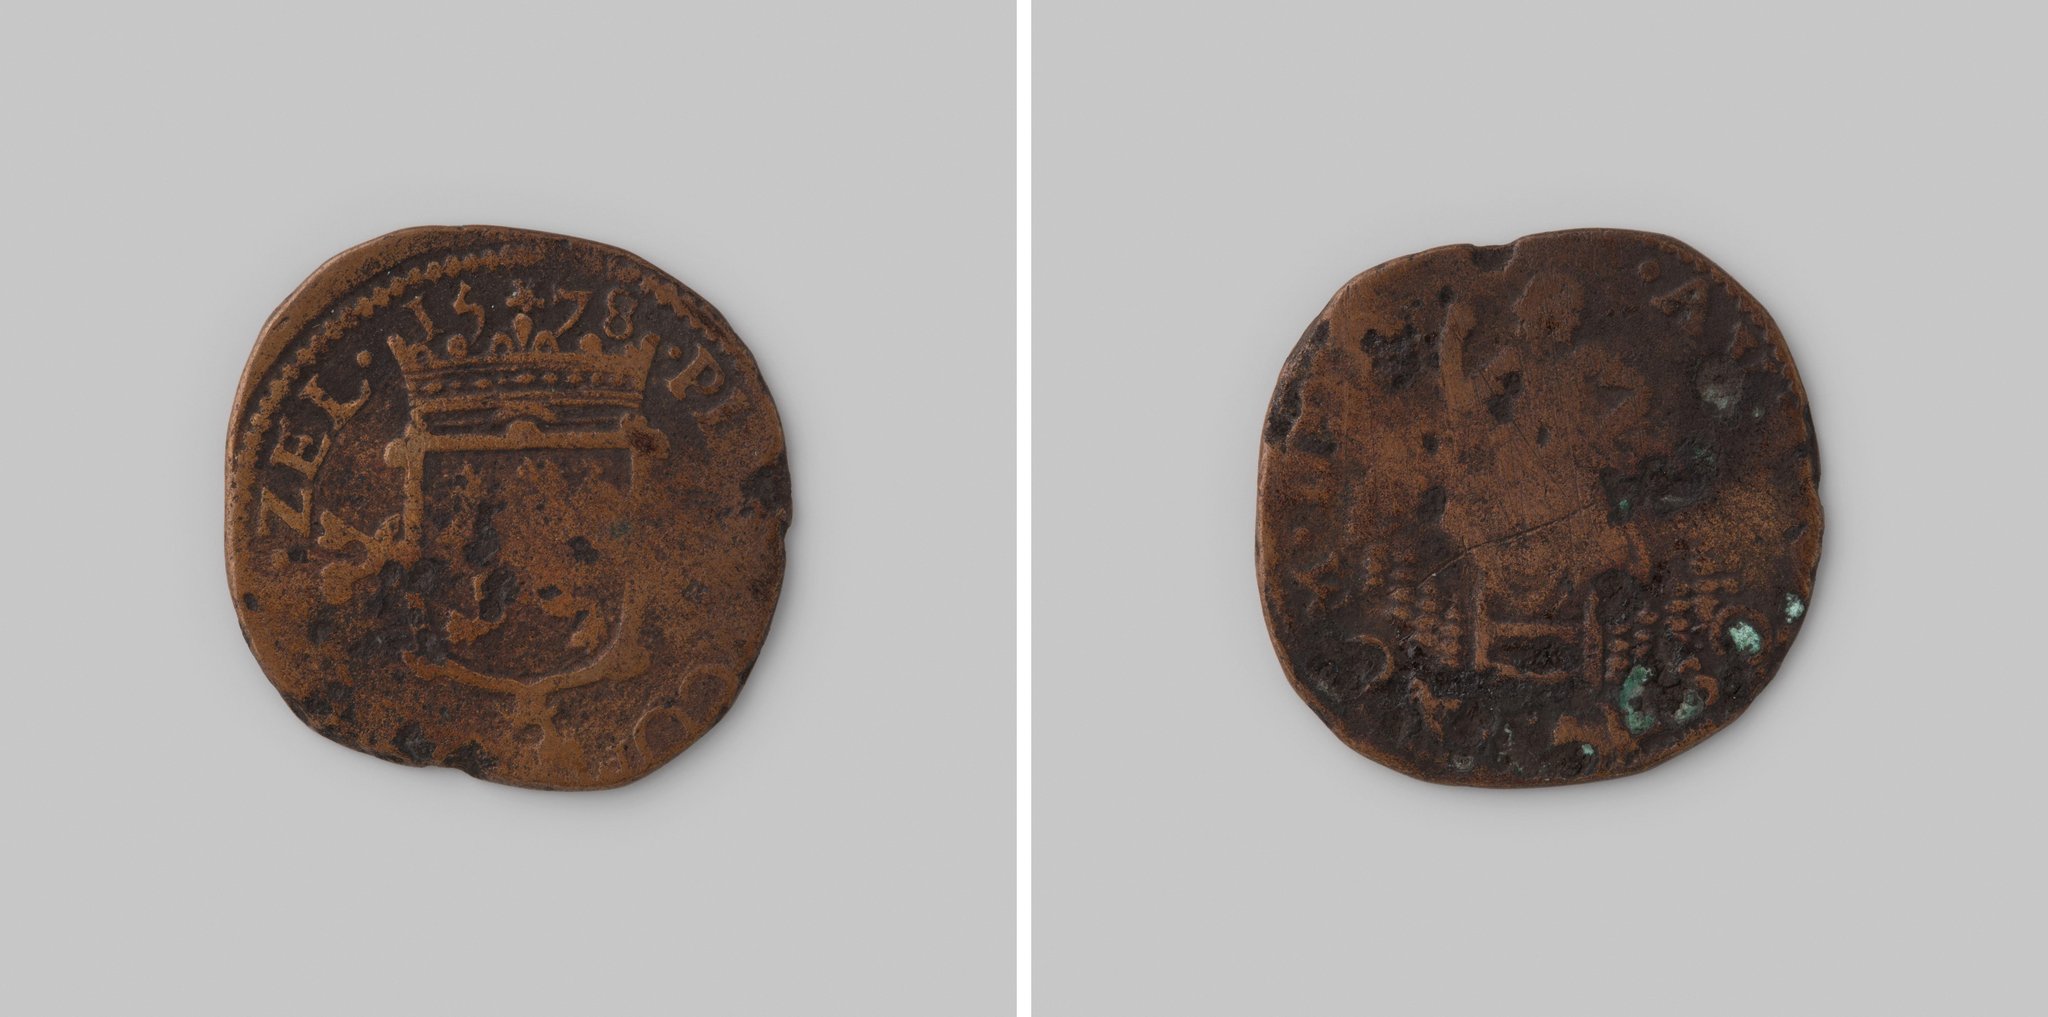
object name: oord, oortje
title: Hollandse oord op naam van Philips II, 1578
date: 1578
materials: copper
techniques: striking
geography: dordrecht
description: Koperen munt. Voorzijde: gekroond wapenschild van Holland op stokkenkruis. In omschrift naam van Philips II en jaartal. Keerzijde: Hollandse maagd met opgestoken rechterarm, zittend in een tuin met gesloten omheining.